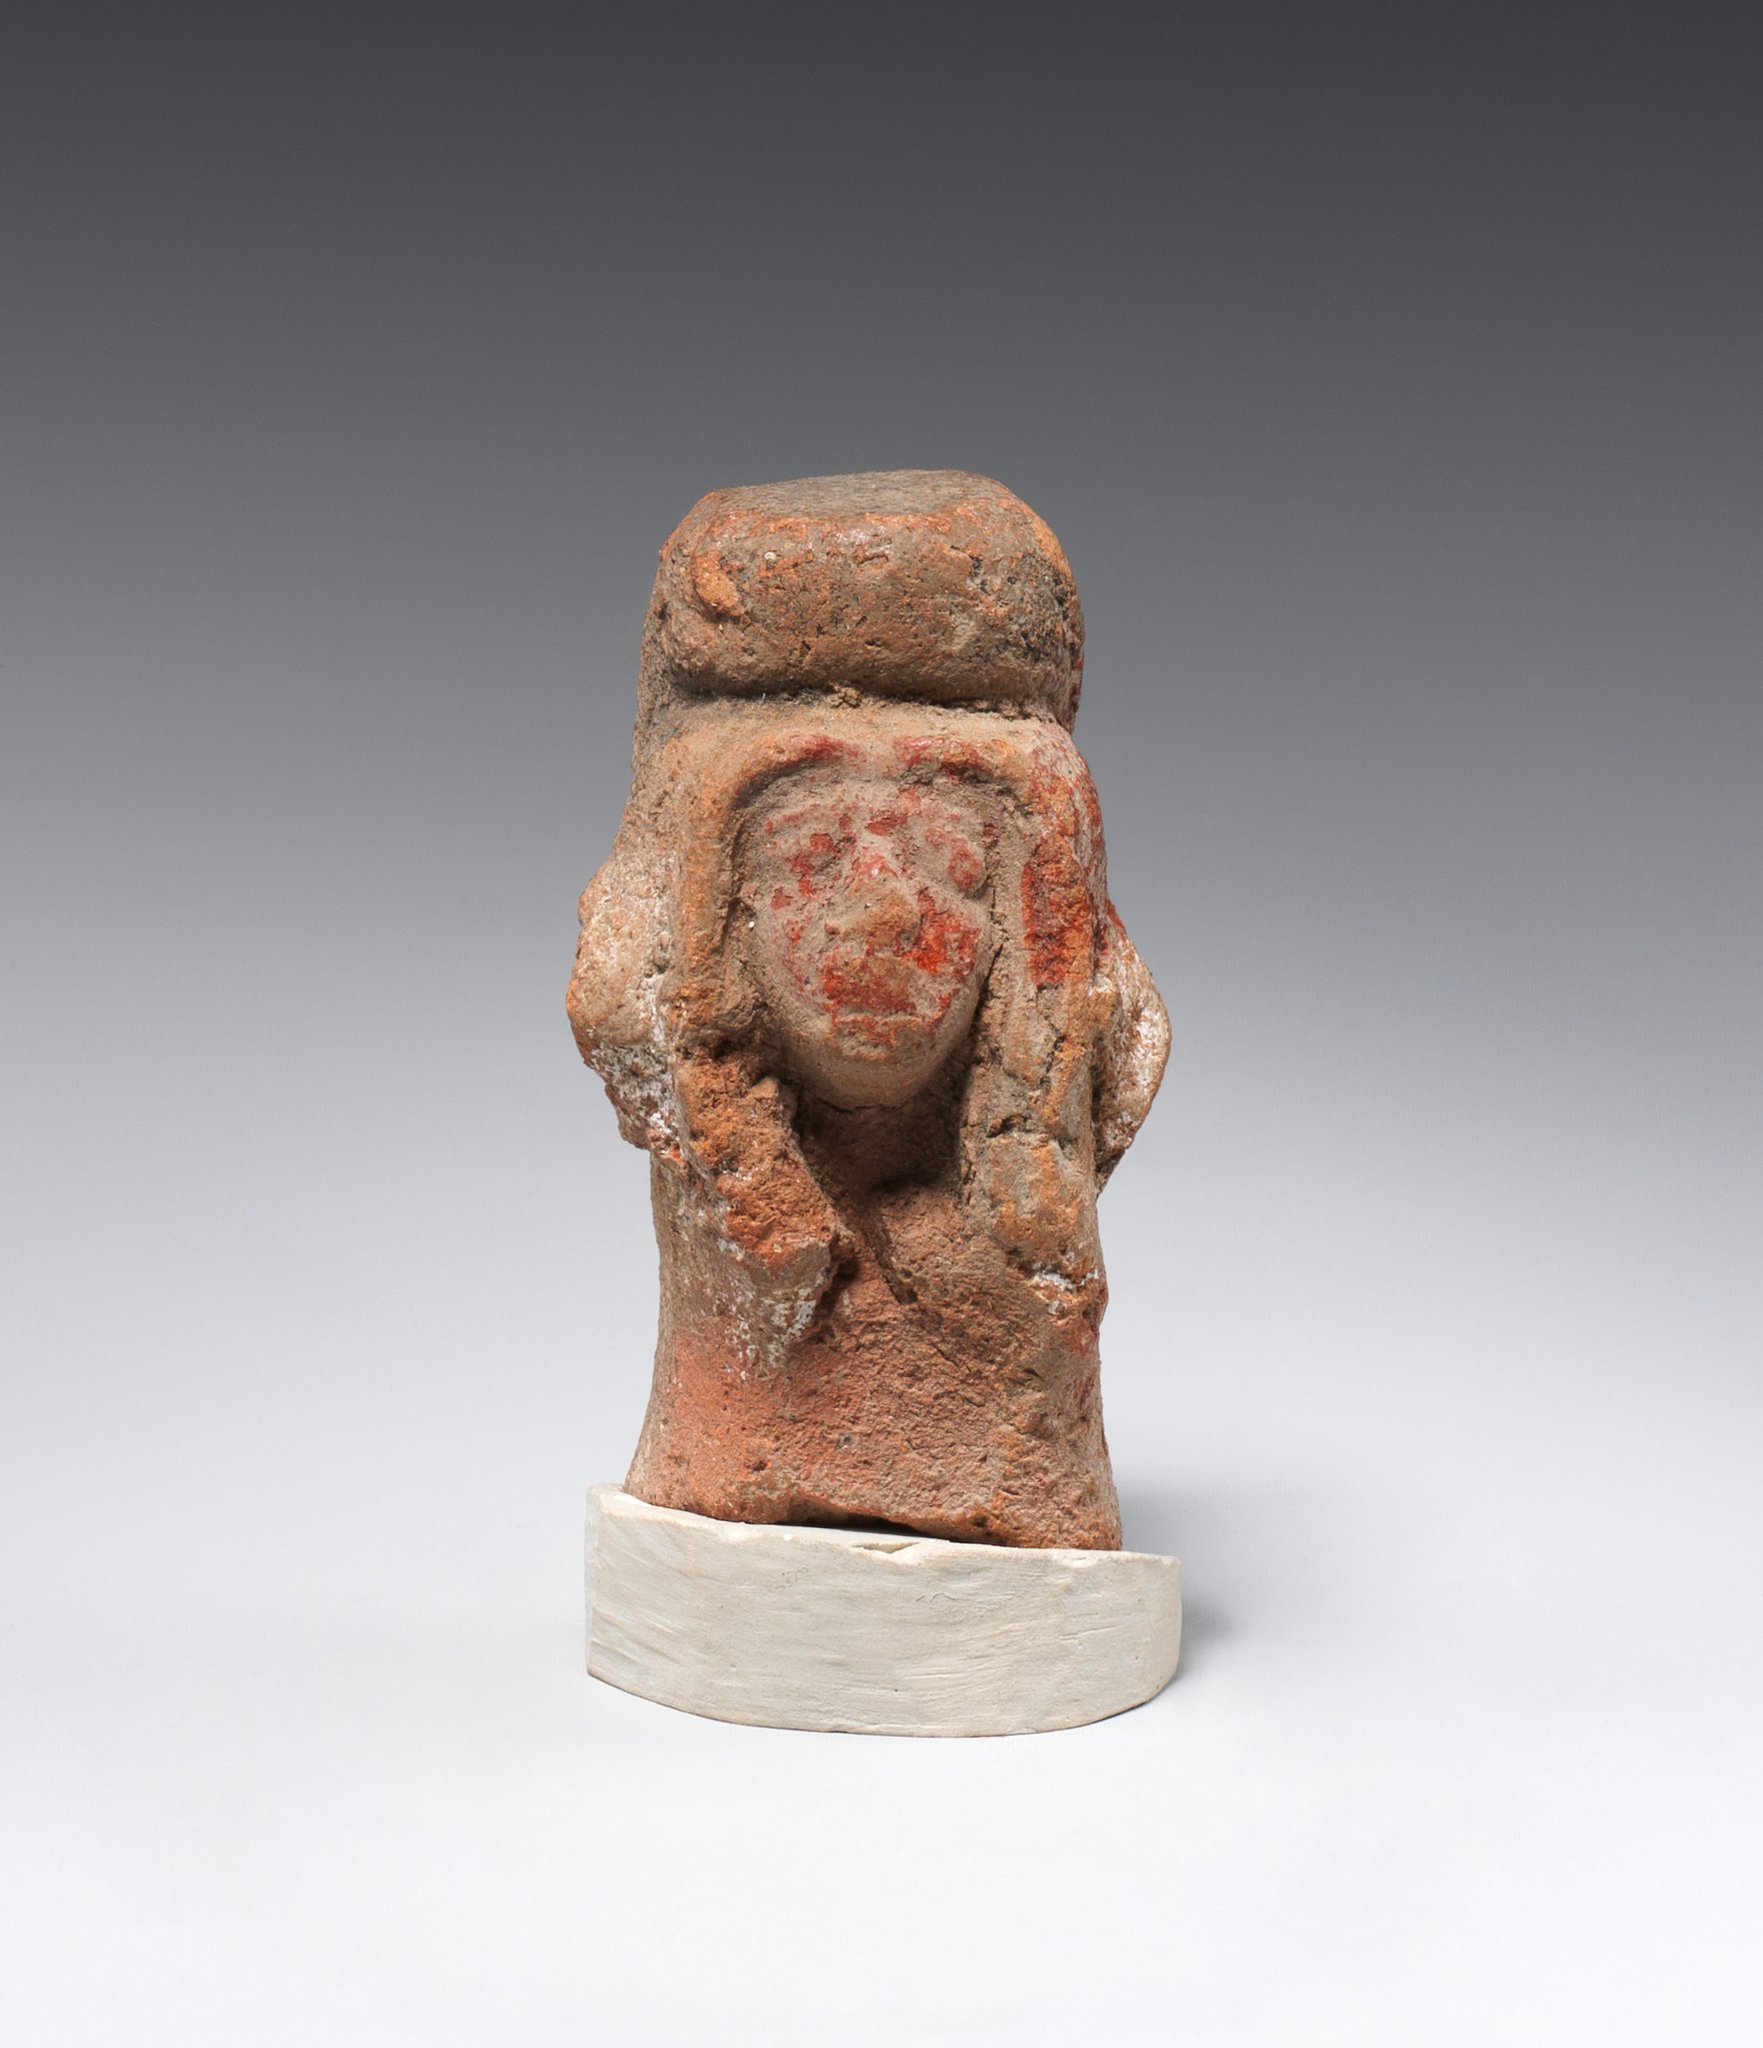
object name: figurine fragment, human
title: Head of Human Figure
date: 306-30 BCE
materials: paint, pottery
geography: egypt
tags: heads